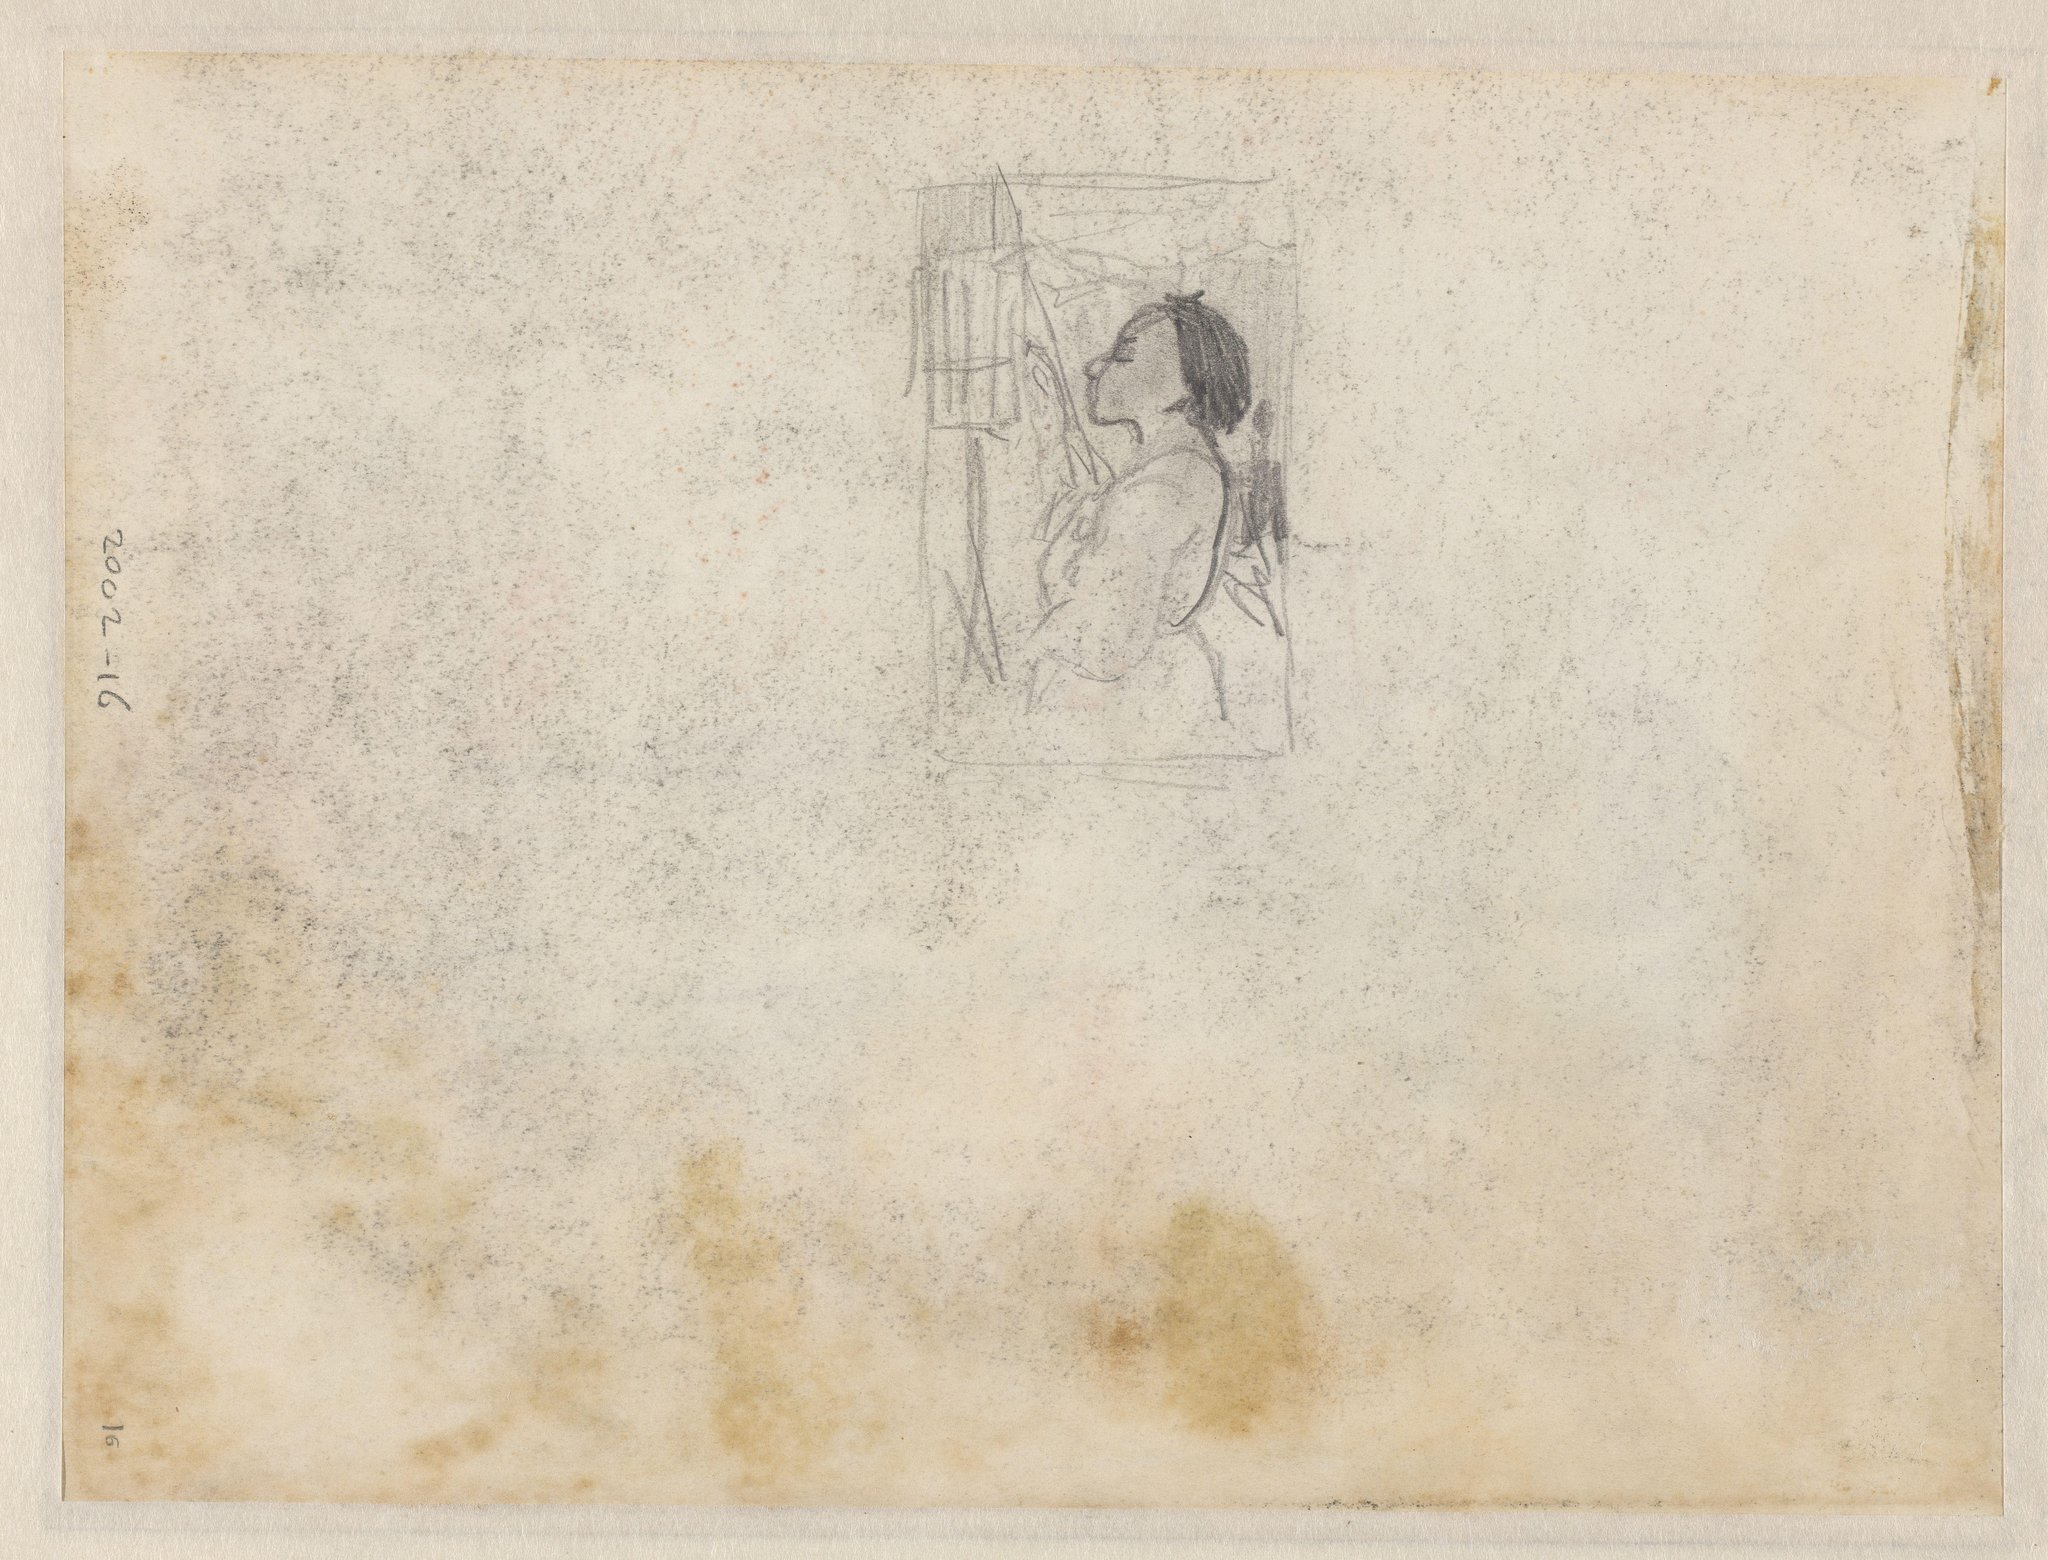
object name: drawing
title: Schets van een meisje bij een vogelkooi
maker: matthijs maris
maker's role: draughtsman, painter, print maker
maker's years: 1839-1917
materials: paper, pencil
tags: bird in a cage